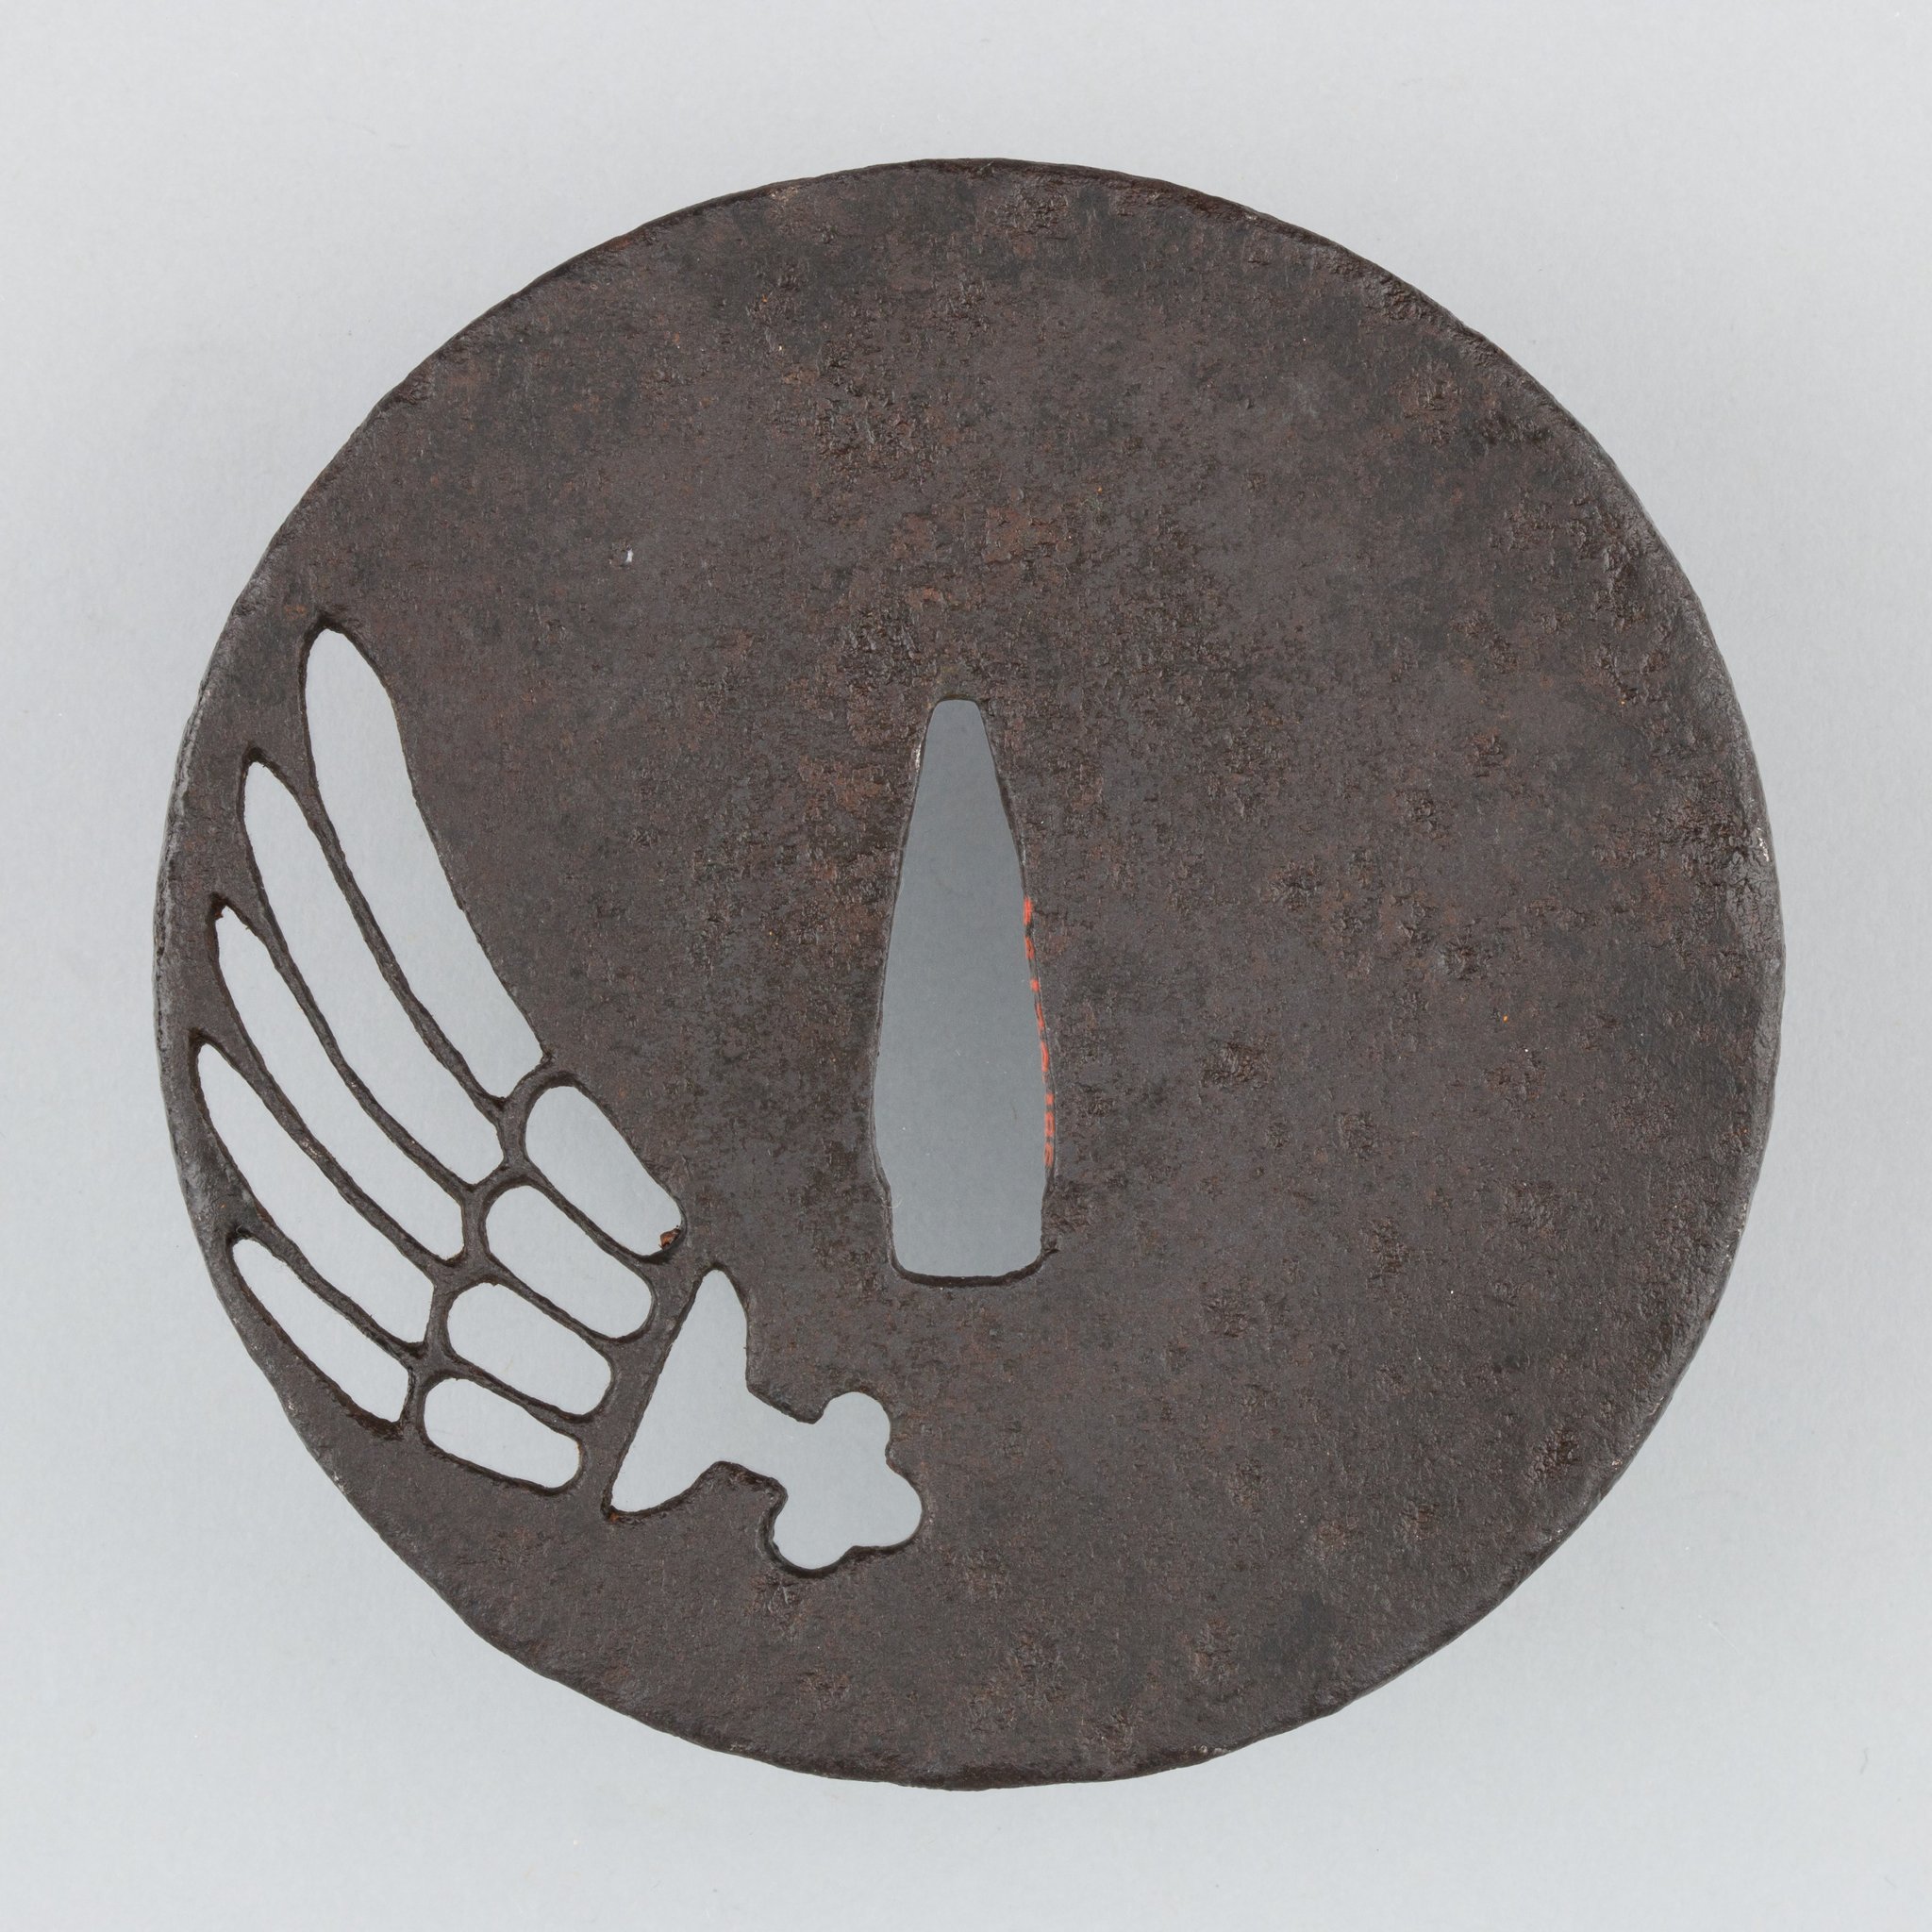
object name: sword guard tsuba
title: Sword Guard (Tsuba)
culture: japanese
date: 1467-1533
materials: copper, iron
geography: japan